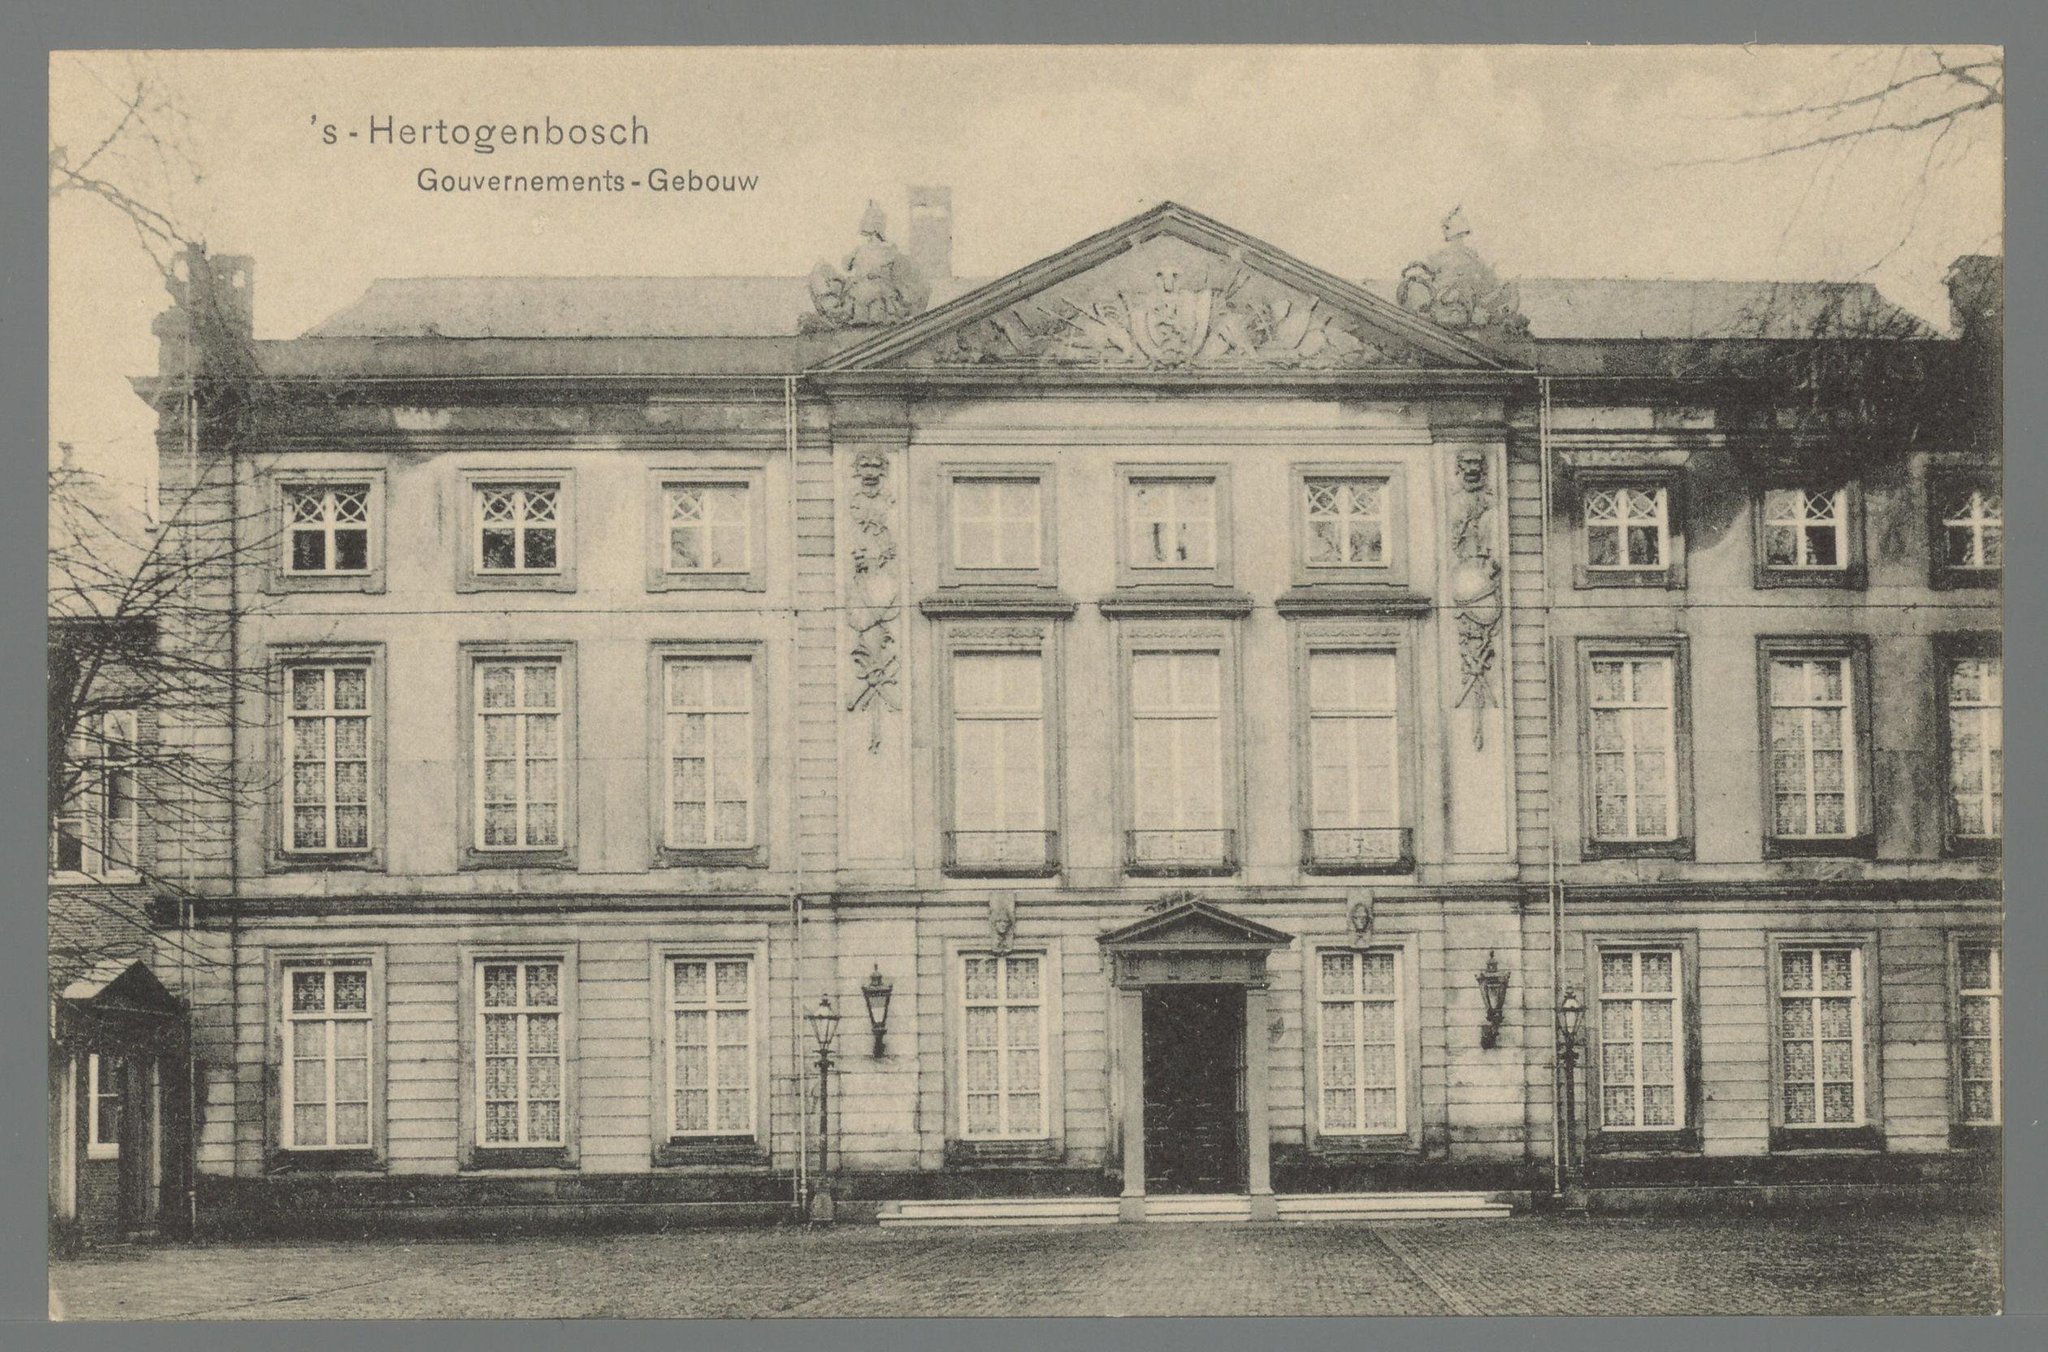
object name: ansichtkaart, prentbriefkaart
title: 's-Hertogenbosch. Gouvernements-Gebouw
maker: Anonymous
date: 1905-1930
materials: cardboard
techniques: photograph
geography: den bosch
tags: façade (of house or building), den bosch